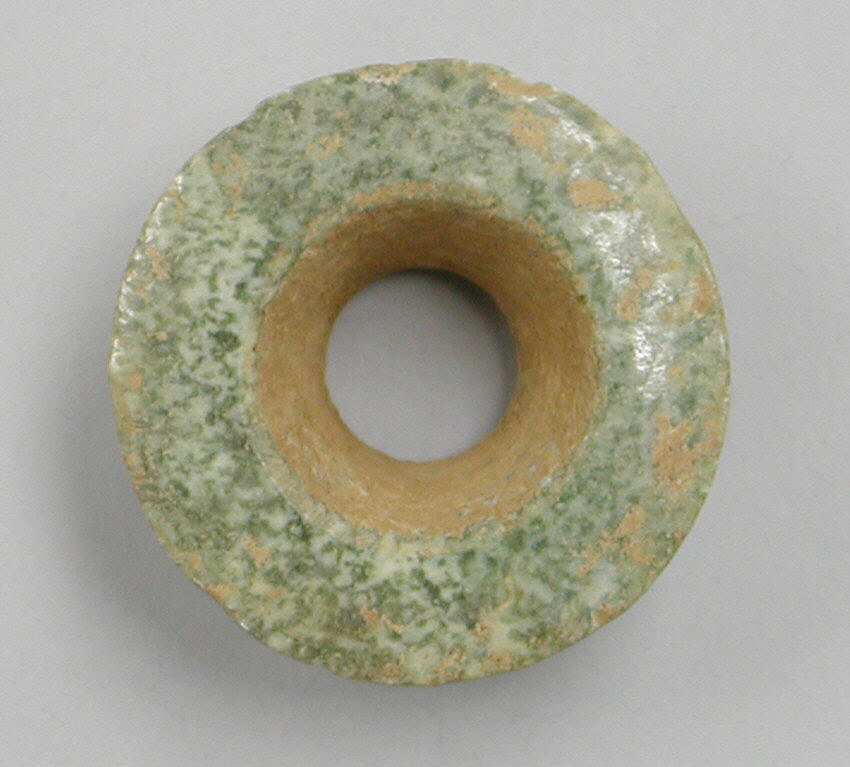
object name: earflare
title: Stone Earflare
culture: mexican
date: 1501-1600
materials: stone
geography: mexico